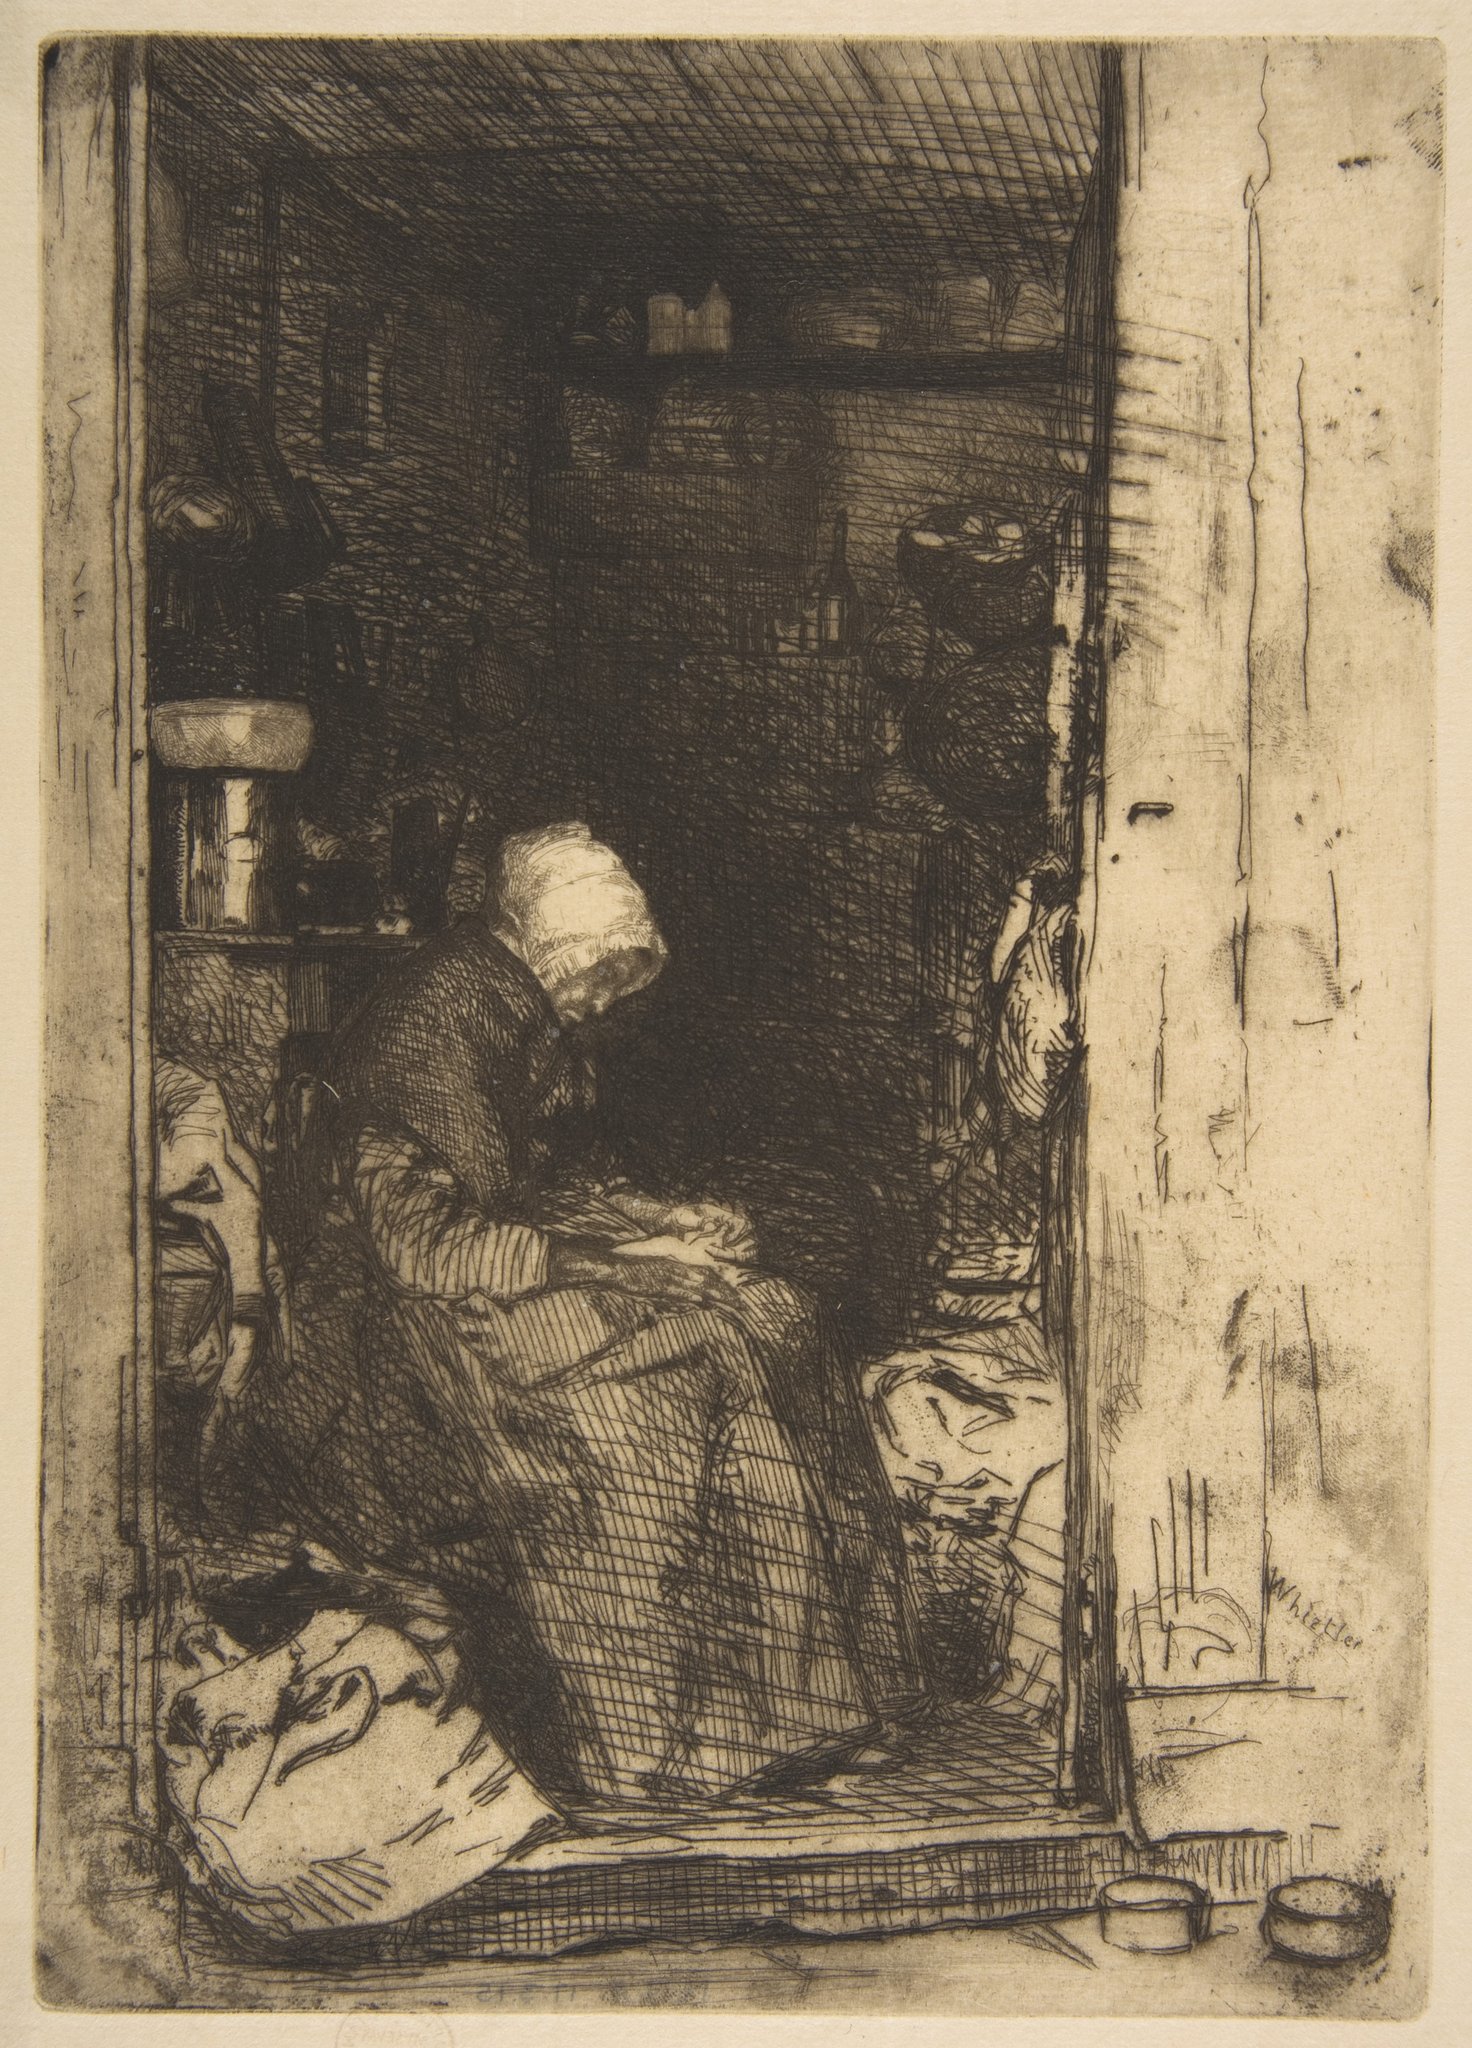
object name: print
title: La Vielle aux Loques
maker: james mcneill whistler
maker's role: artist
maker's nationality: american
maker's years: 1834-1903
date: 1858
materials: ink, paper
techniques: drypoint, etching, printing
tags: women